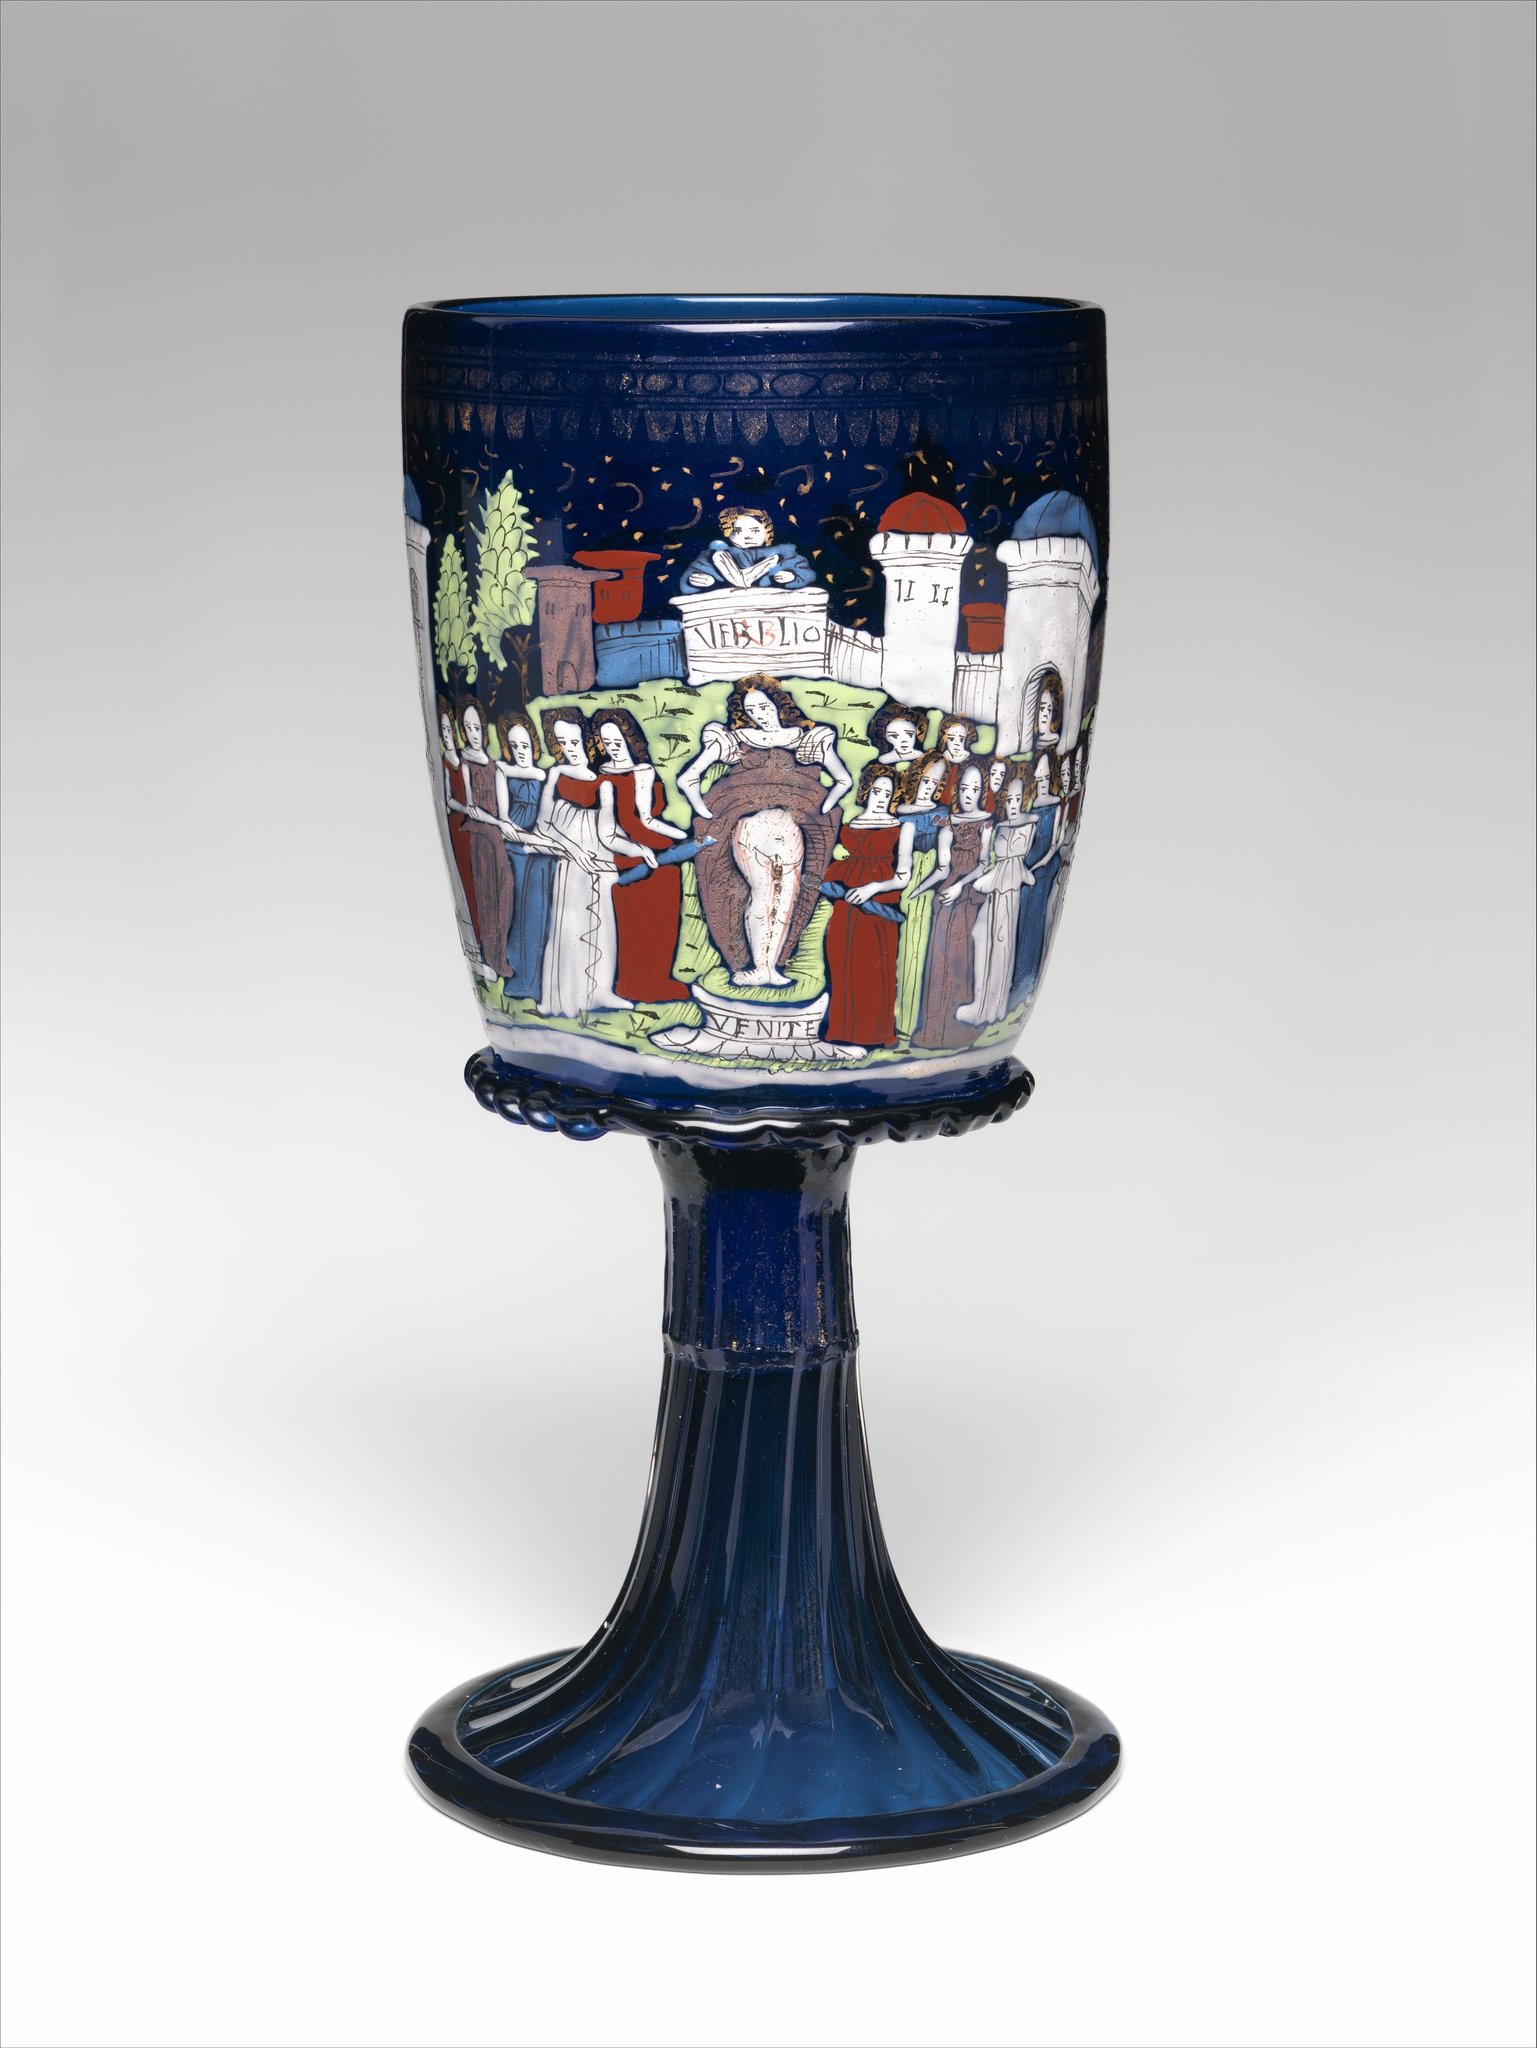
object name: goblet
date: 1475-1500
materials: glass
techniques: enamel, gilding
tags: women